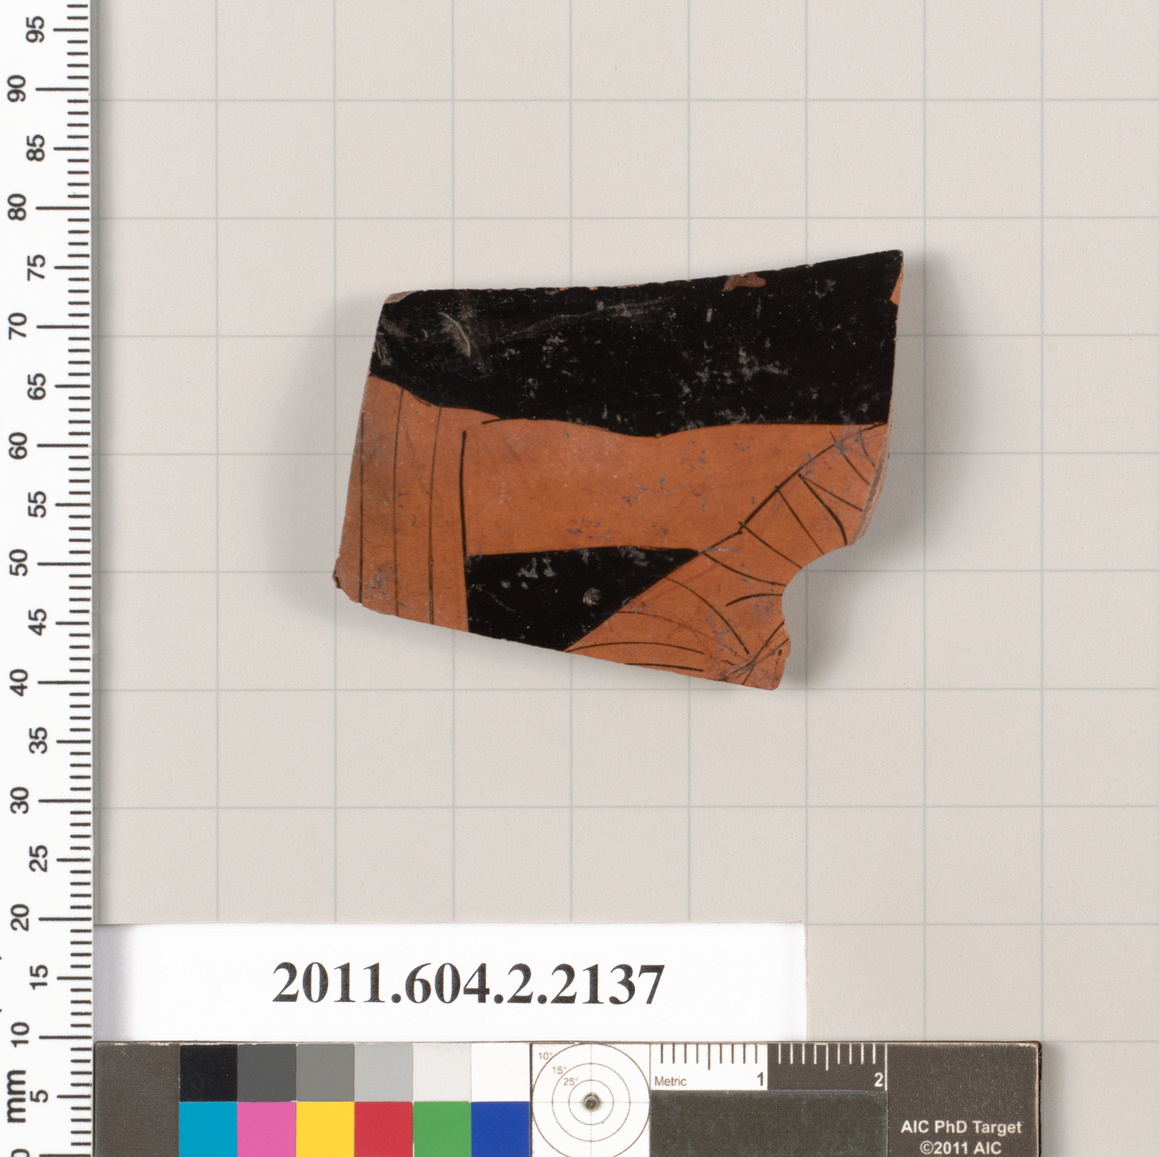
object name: pot fragment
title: Terracotta fragment of a pot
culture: greek, attic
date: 475-451 BCE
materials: terracotta